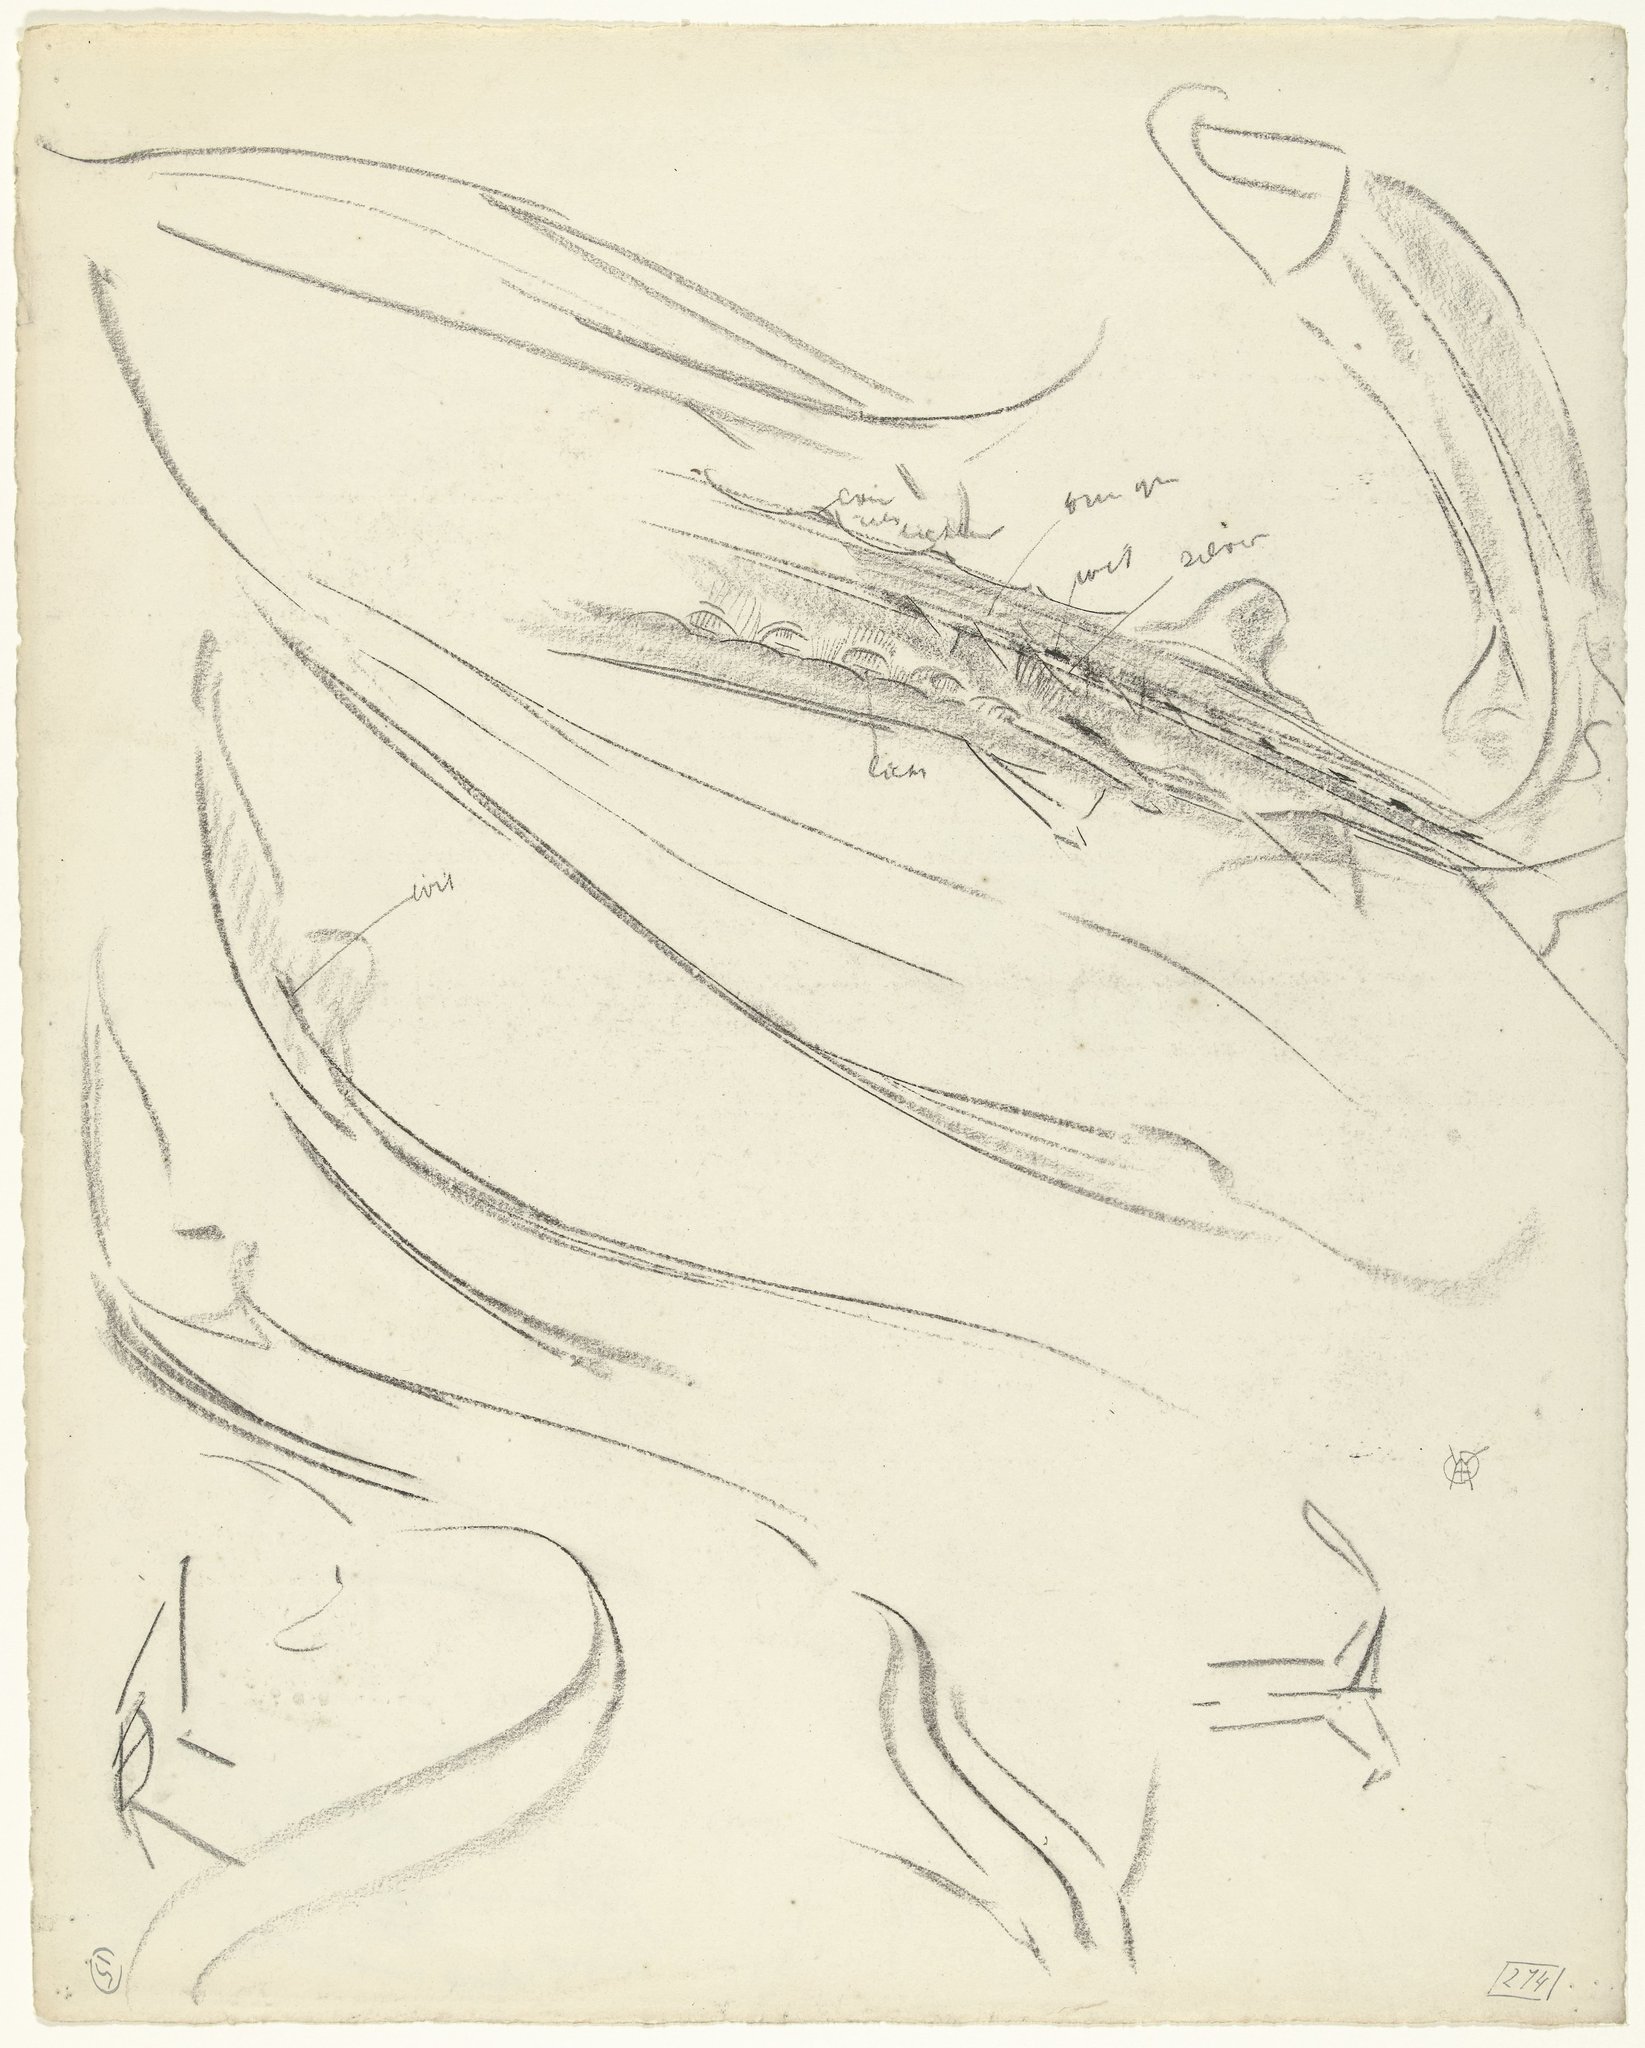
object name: drawing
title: Studies van een sterlet, met kleurnotities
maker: gerrit willem dijsselhof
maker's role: designer, draughtsman, print maker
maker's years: 1866-1924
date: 1876-1924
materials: chalk, paper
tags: bony fishes